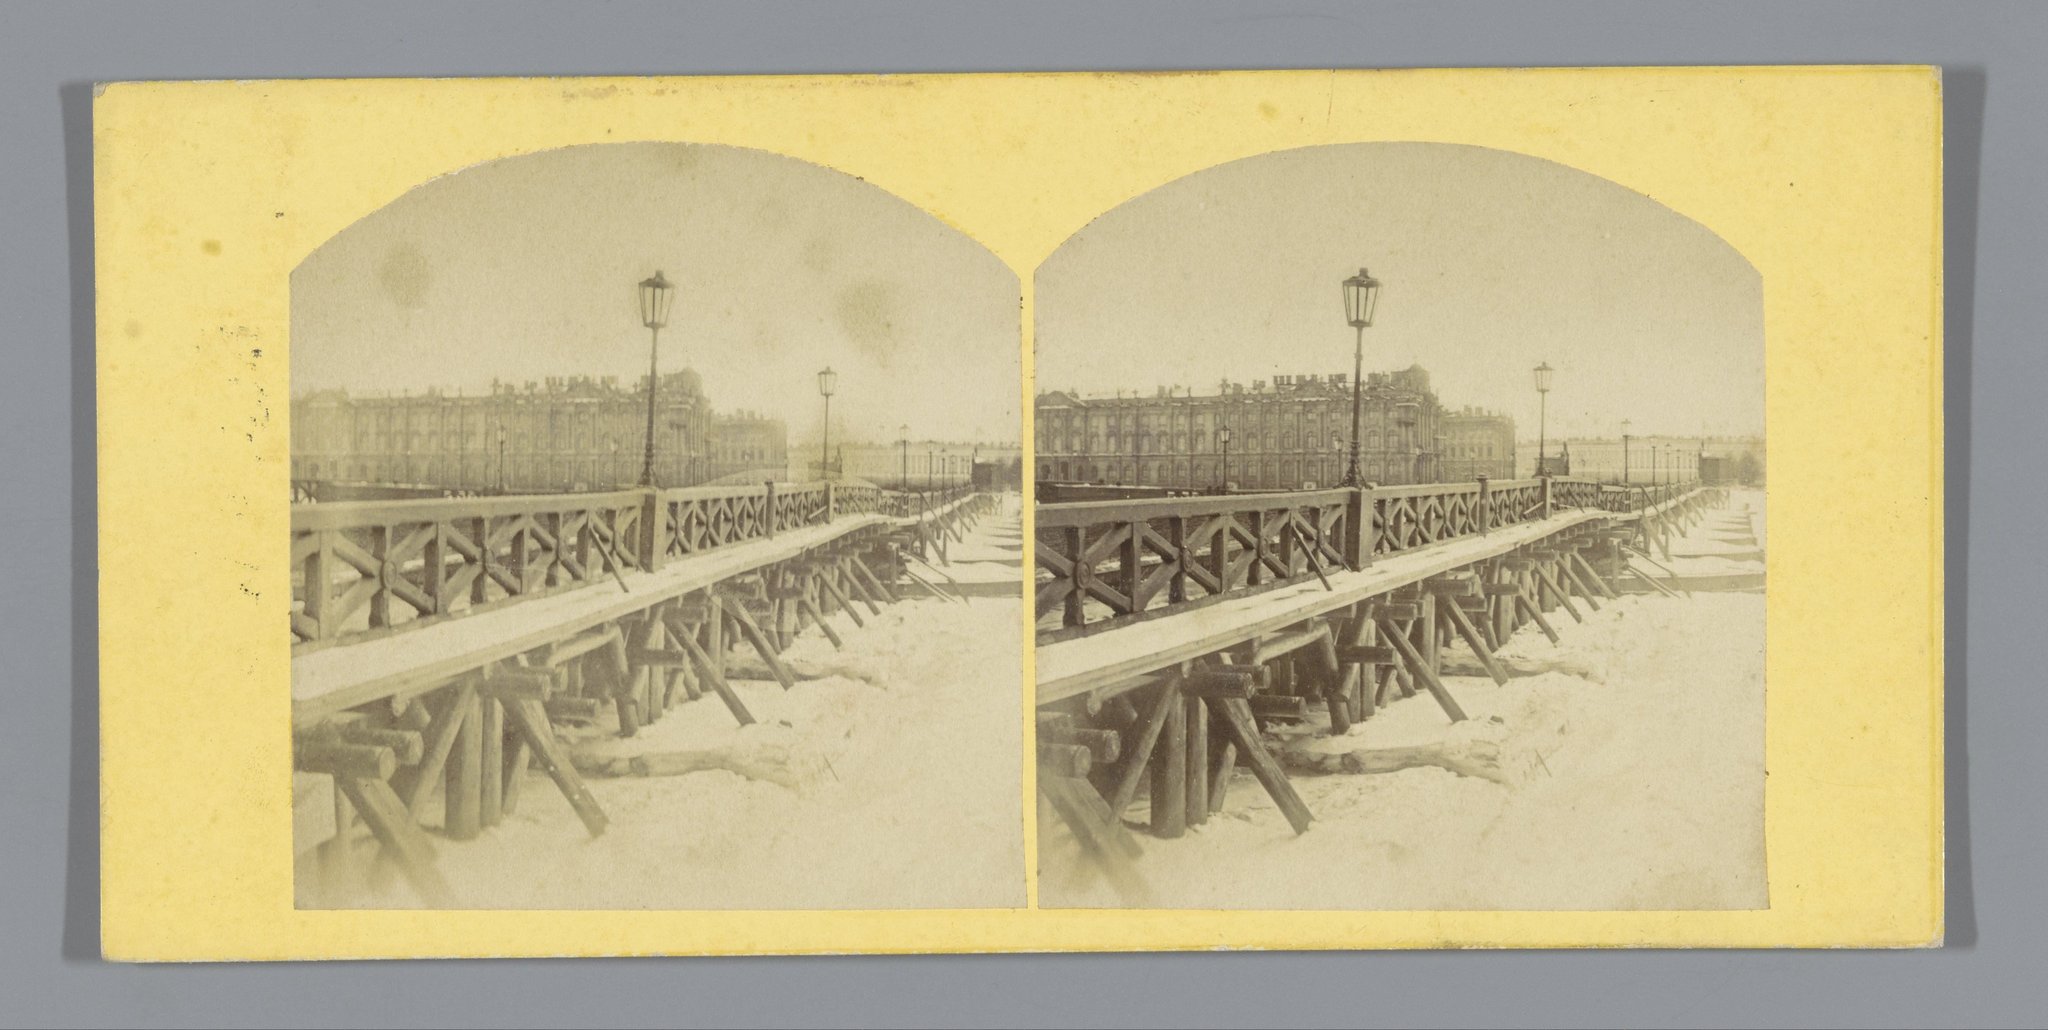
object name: stereograph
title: Brug over de rivier de Neva in Sint-Petersburg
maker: Anonymous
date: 1850-1880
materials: cardboard, photographic support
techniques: albumen print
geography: sint-petersburg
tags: bridge in city across river, canal, etc.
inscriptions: inscription: ‘St. Pétersbourg Pont sur la Nerva’